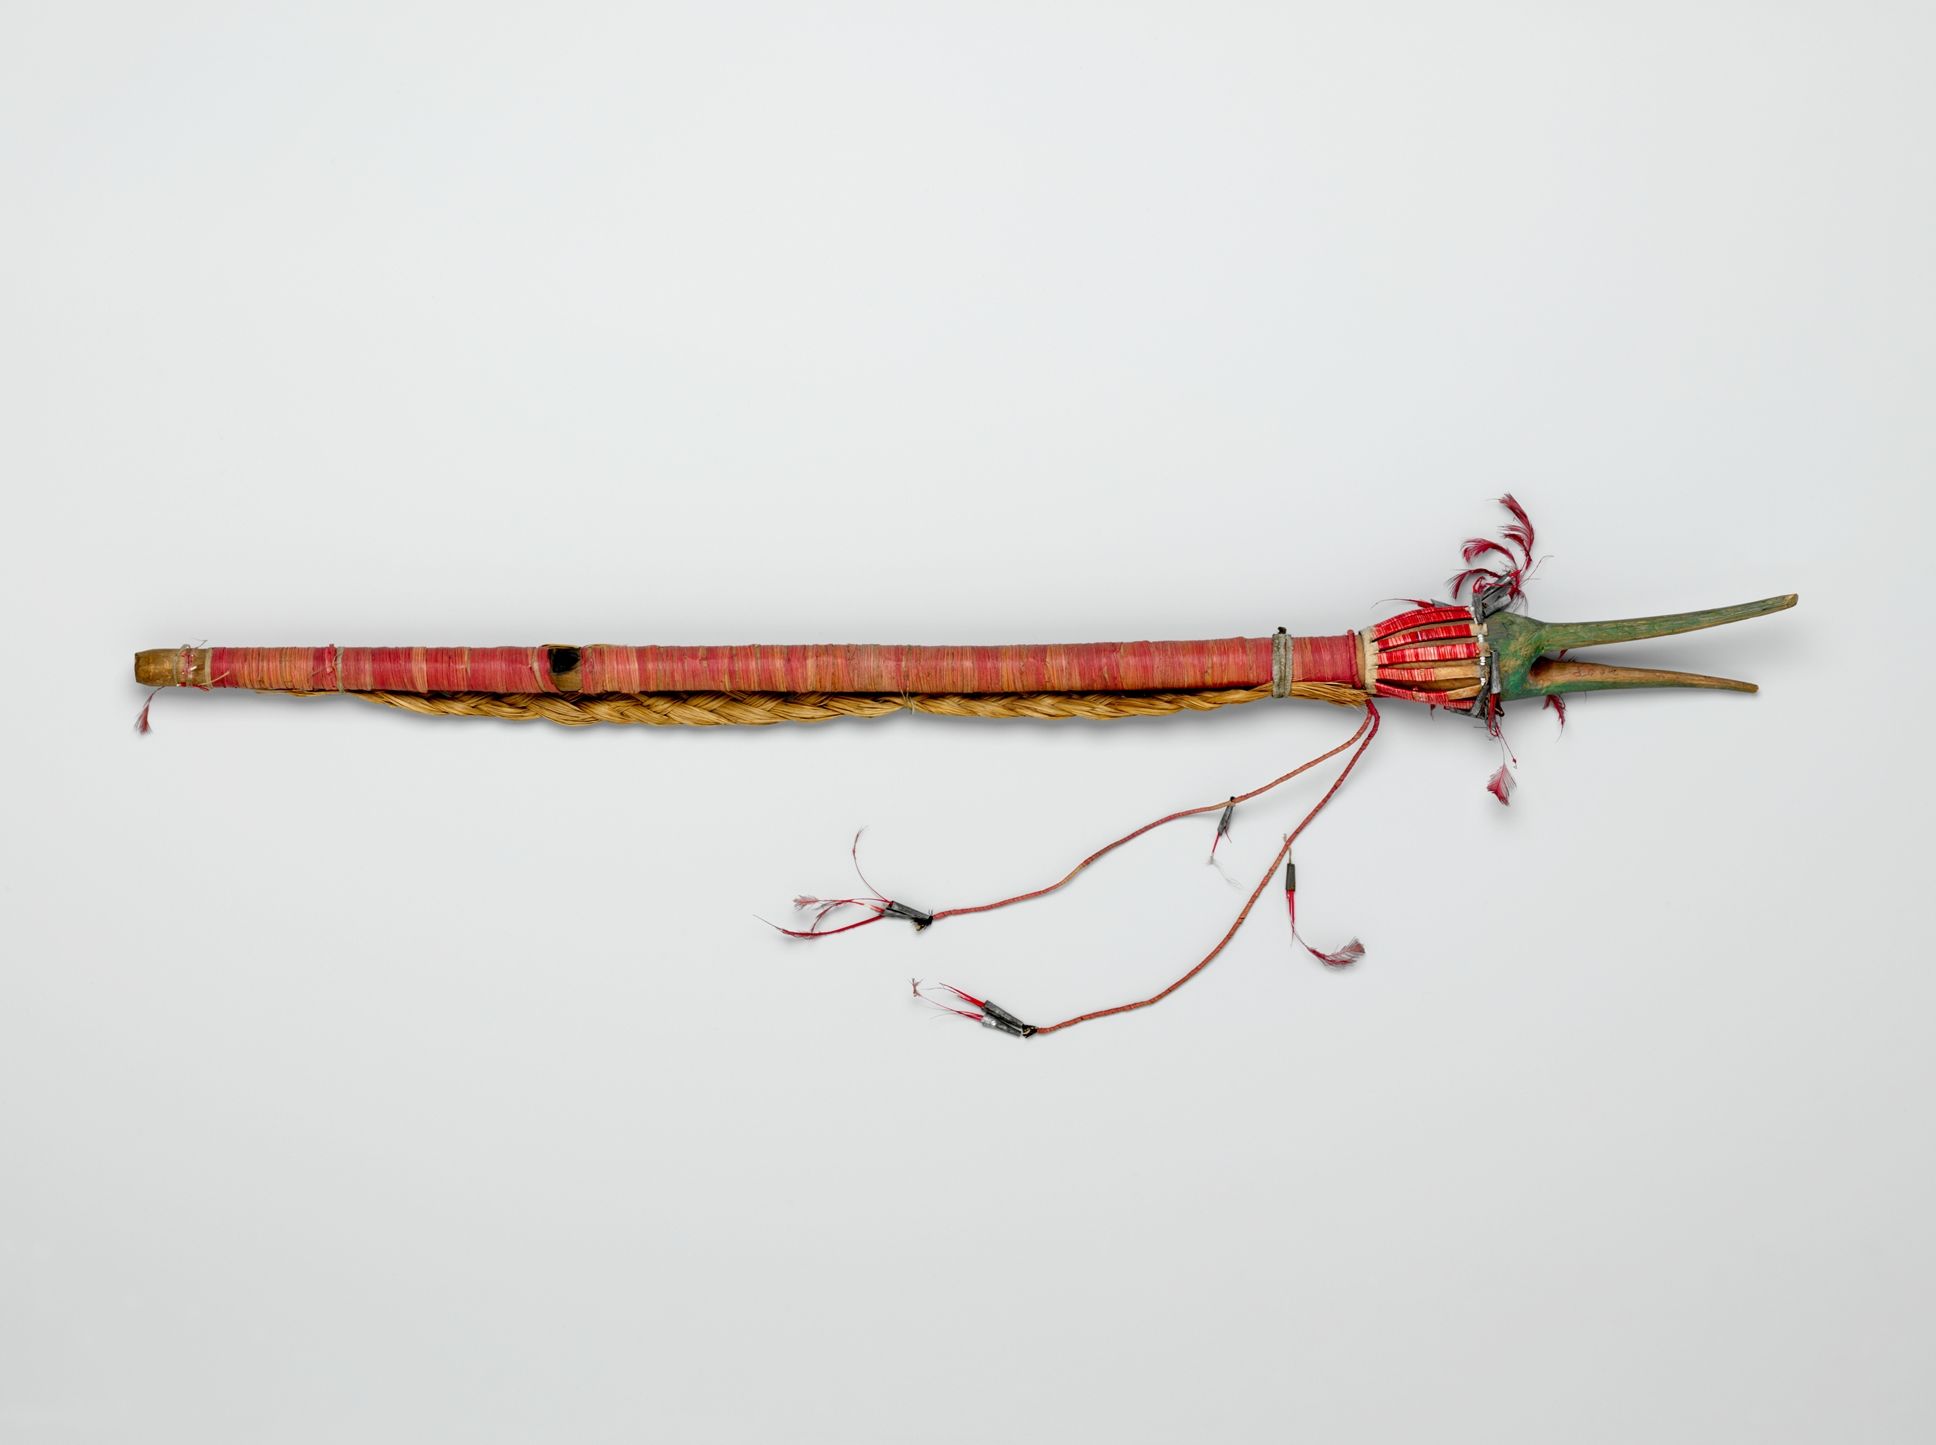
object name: whistle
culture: native american or sioux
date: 1801-1900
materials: tin, wood